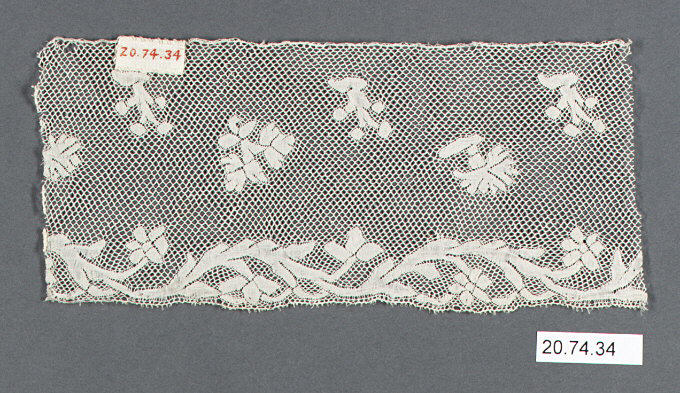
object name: border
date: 1767-1800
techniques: lace